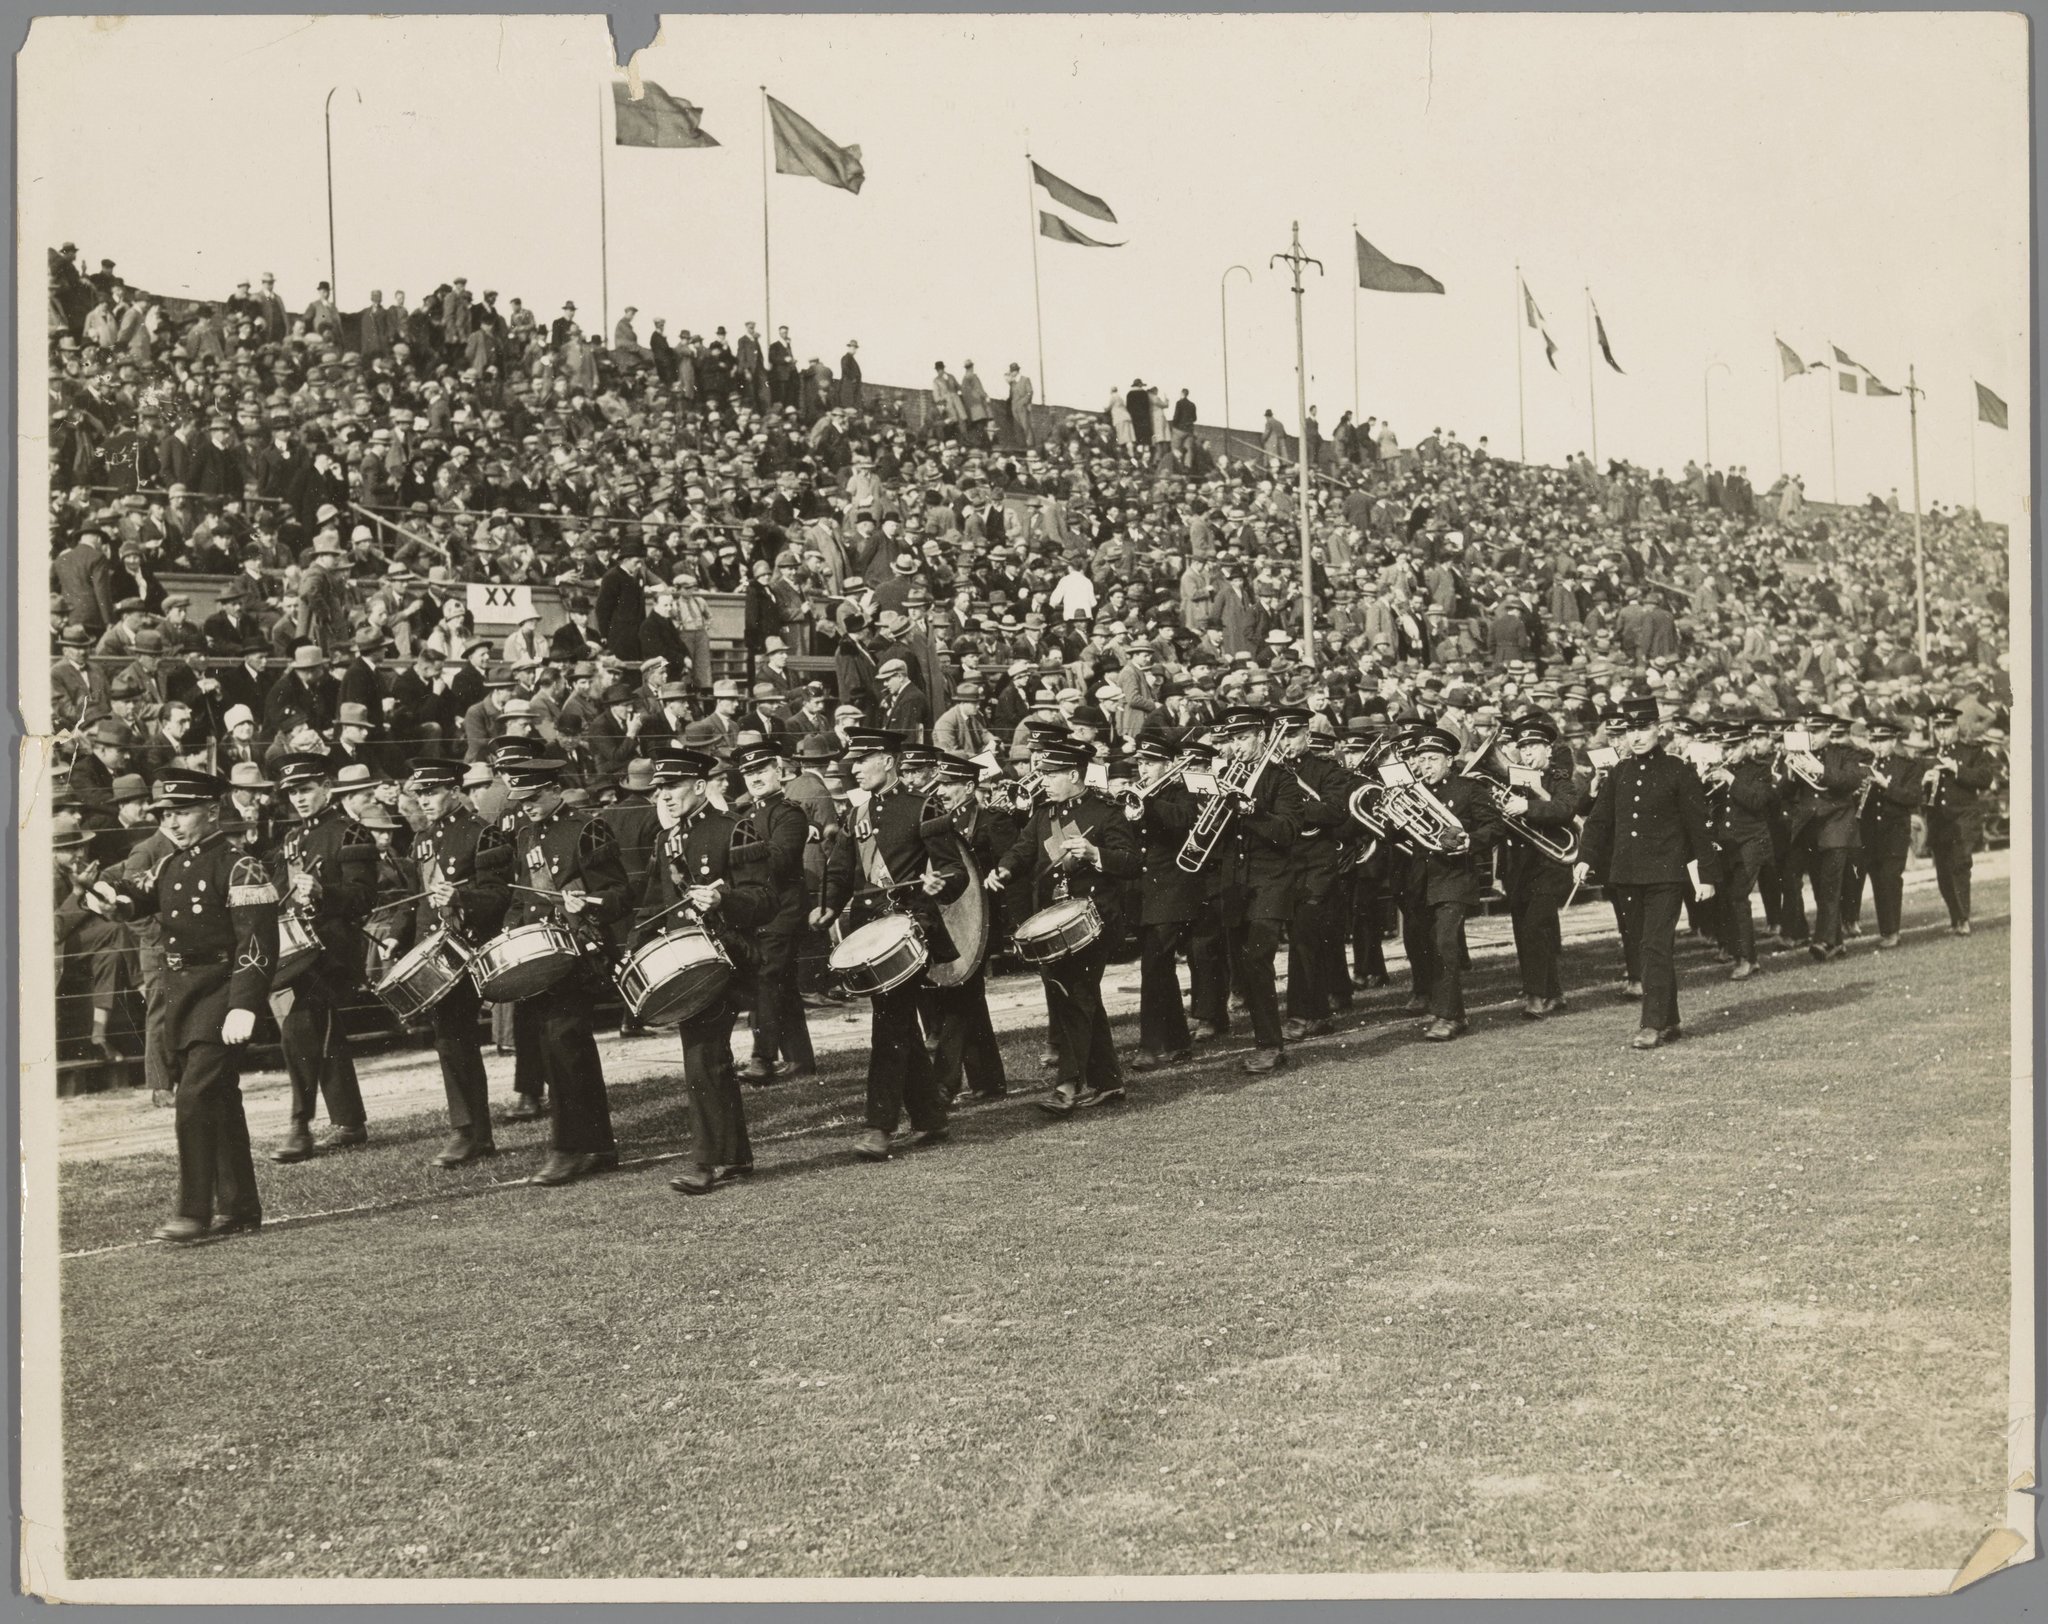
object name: photograph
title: Amsterdamsche Postharmonie in een vol stadion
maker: Anonymous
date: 1923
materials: cardboard, photographic support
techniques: gelatin silver print